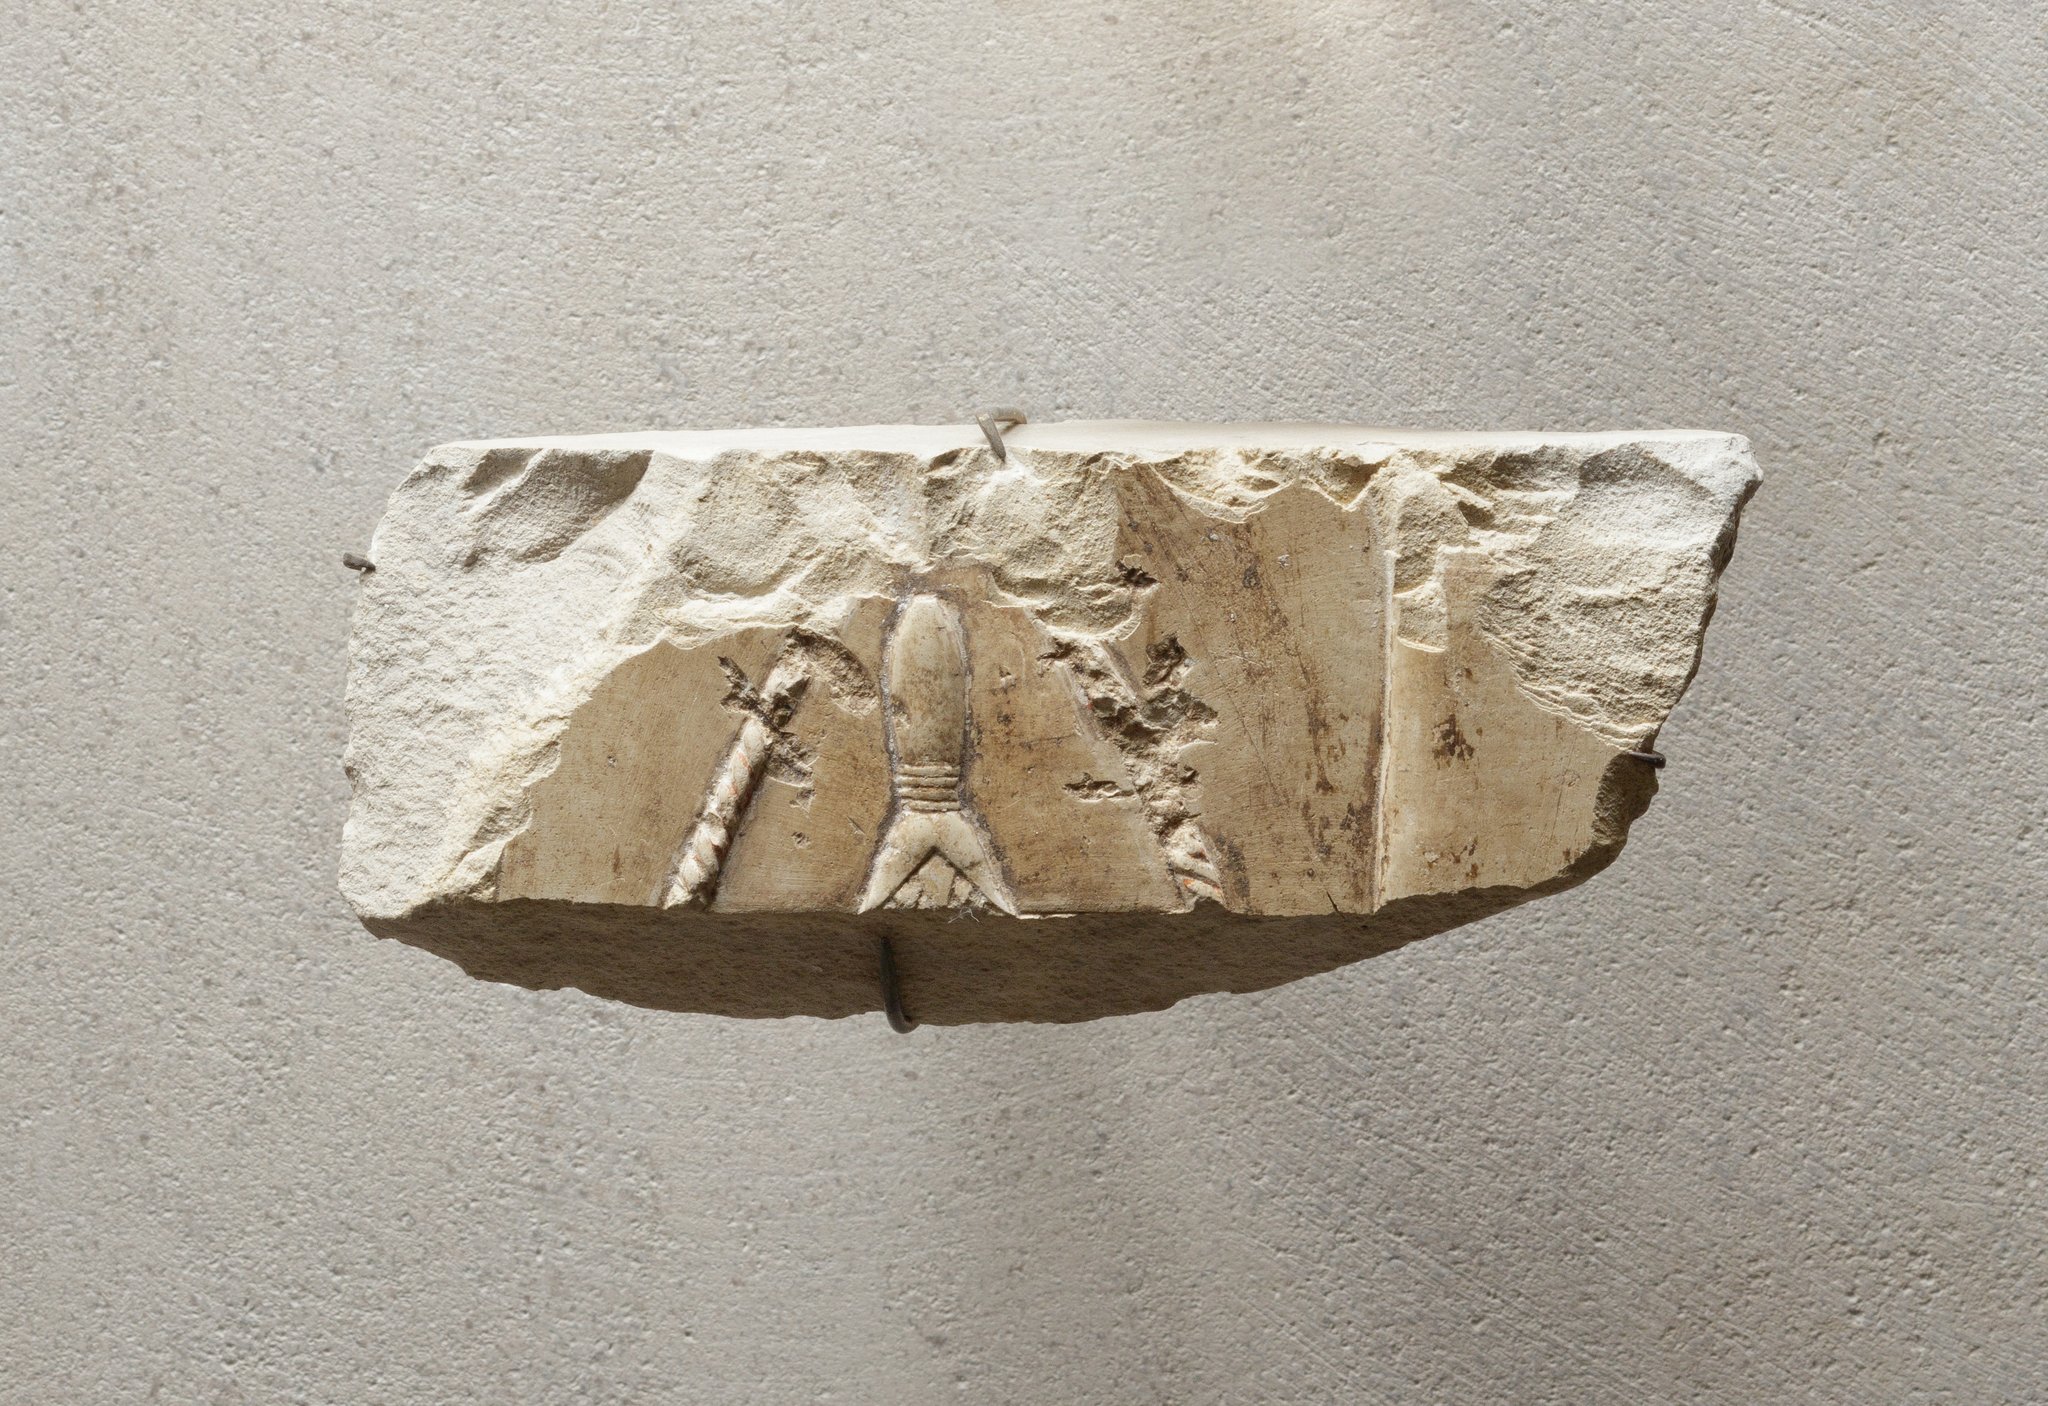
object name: relief, handle of a mirror, neferu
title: Relief showing the handle of a mirror - see 26.3.353-3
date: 2051-2030 BCE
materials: limestone, paint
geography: egypt